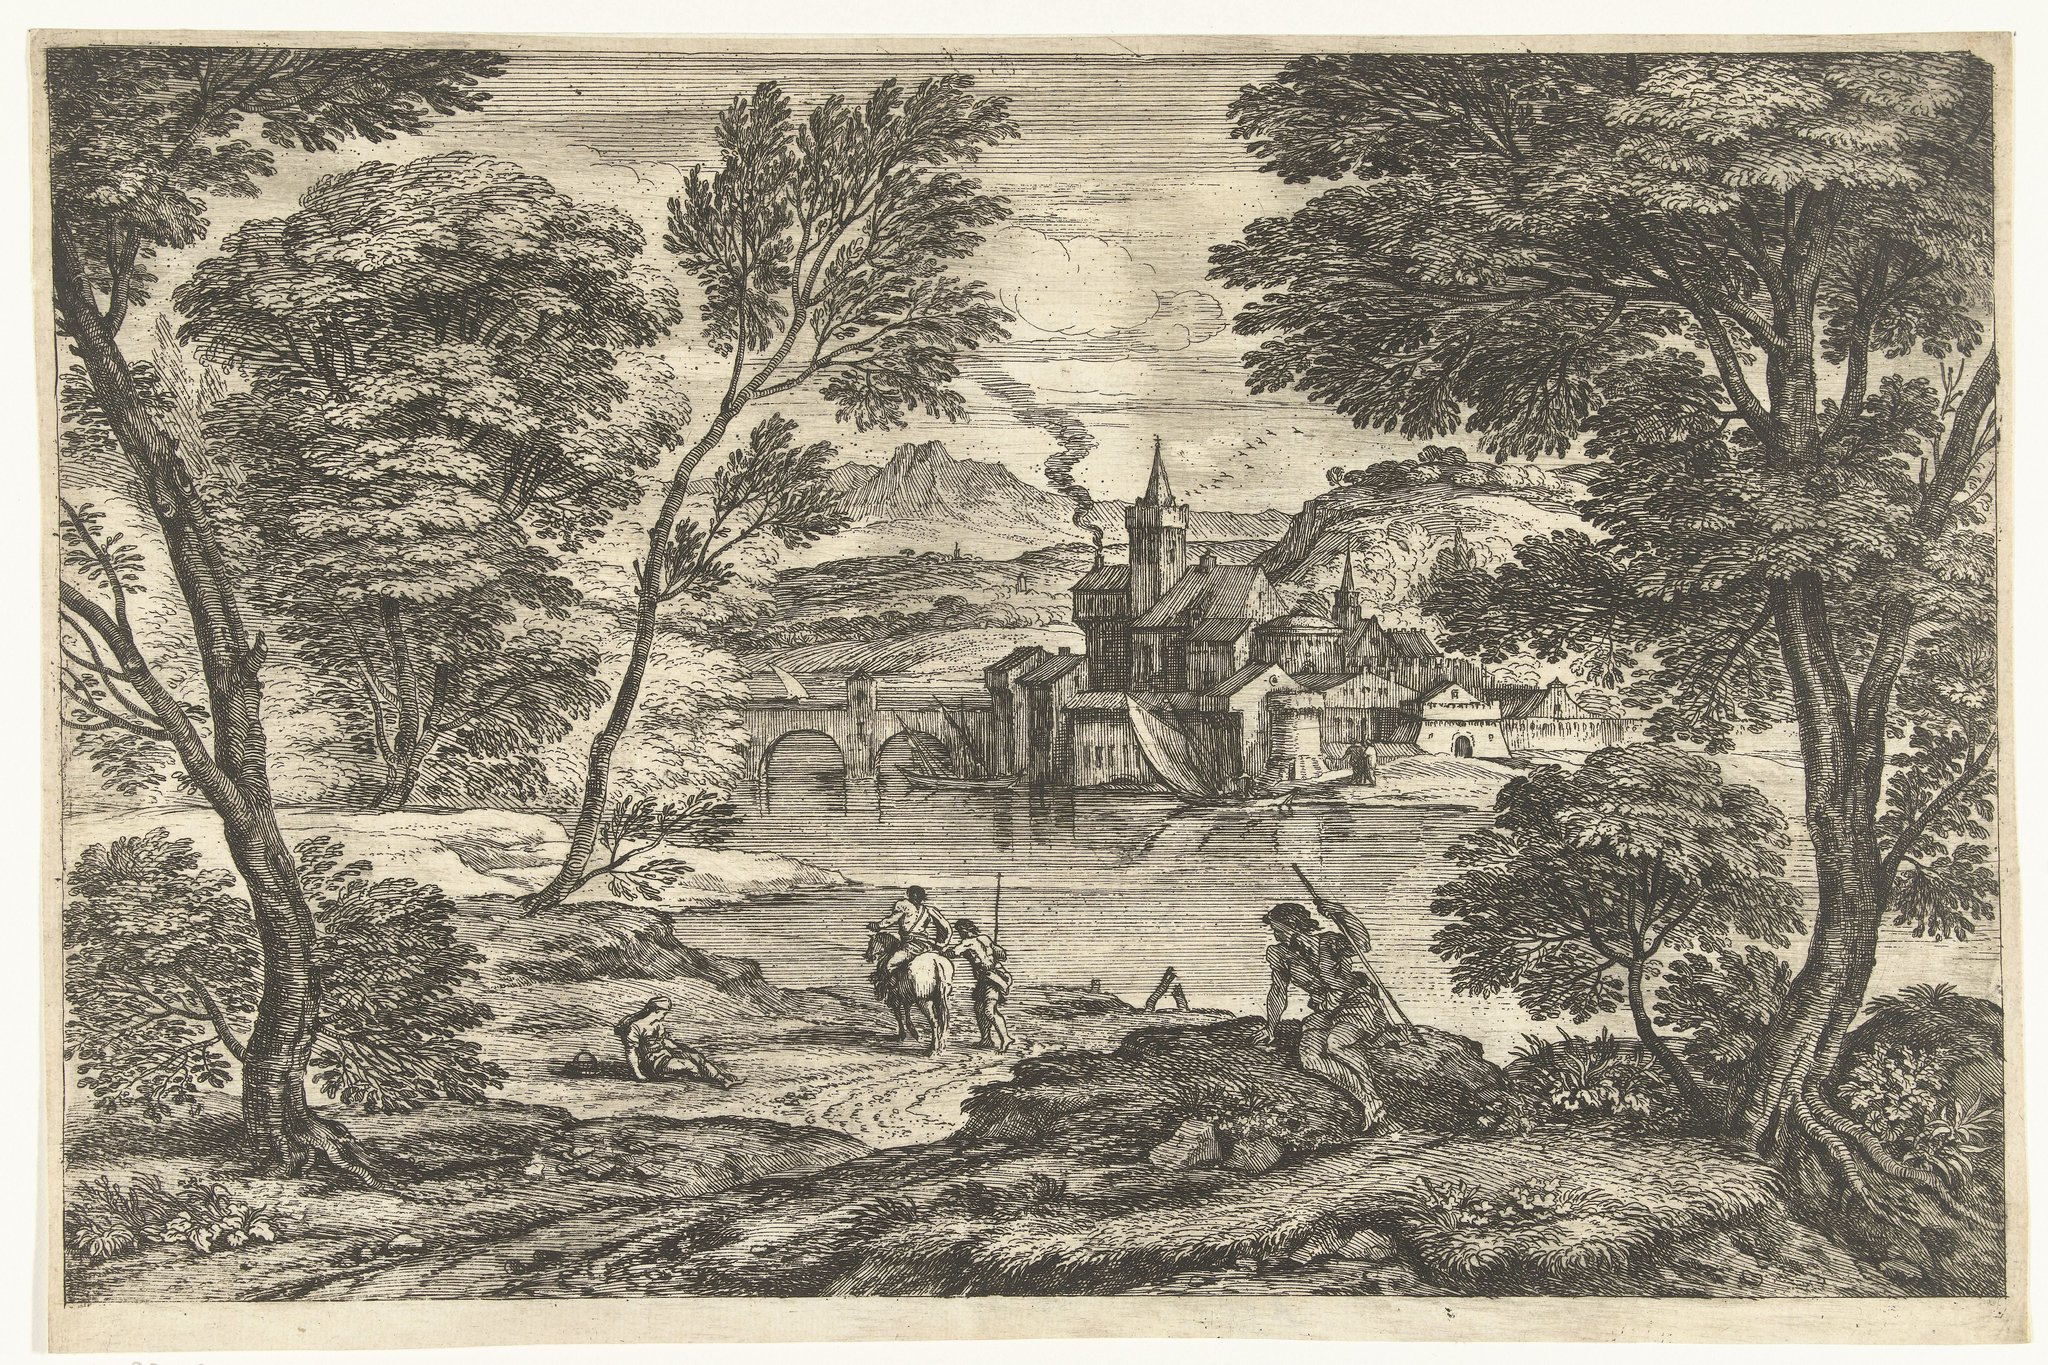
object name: print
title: Landschap met man te paard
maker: adriaen van der kabel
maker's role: draughtsman, painter, print maker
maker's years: 1630-1705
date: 1648-1705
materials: paper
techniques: etching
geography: france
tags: landscapes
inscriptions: collector's mark: Lugt 2228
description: Landschap met op de voorgrond een zittende man met lange stok in linker hand, kijkend in de richting van zittende vrouw en man te paard met begeleider. Op de achtergrond een stad aan het water. Vijfde prent uit de serie van zes.